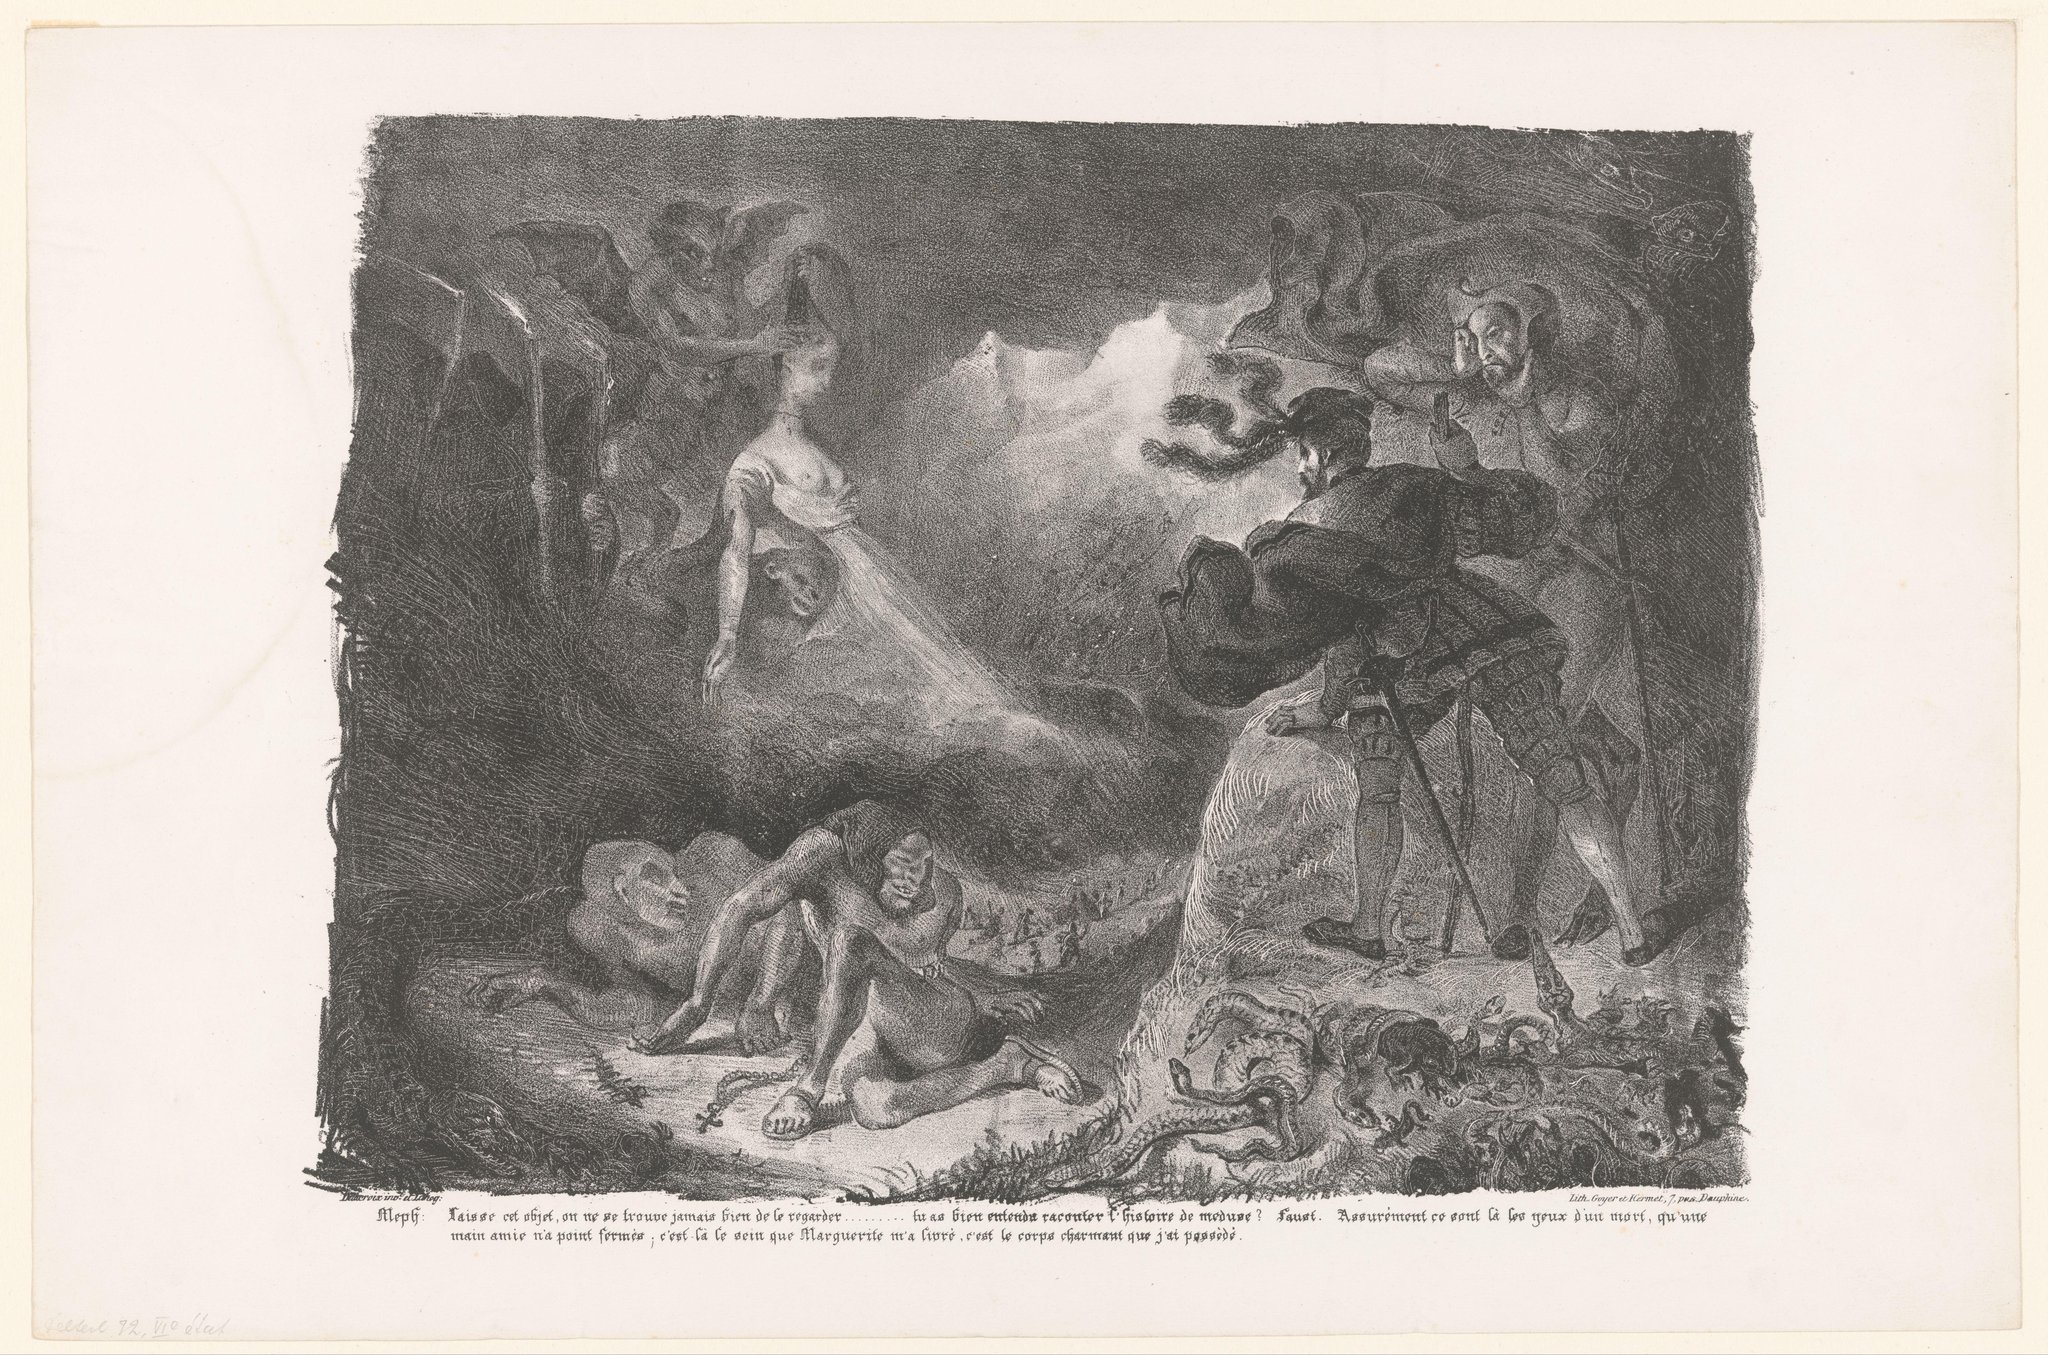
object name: print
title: Faust, tragédie de M. de Goethe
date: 1828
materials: paper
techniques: lithograph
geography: paris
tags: (scenes from) specific works of literature: goethe, faust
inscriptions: collector's mark: Lugt 2228a, collector's mark: Lugt 964